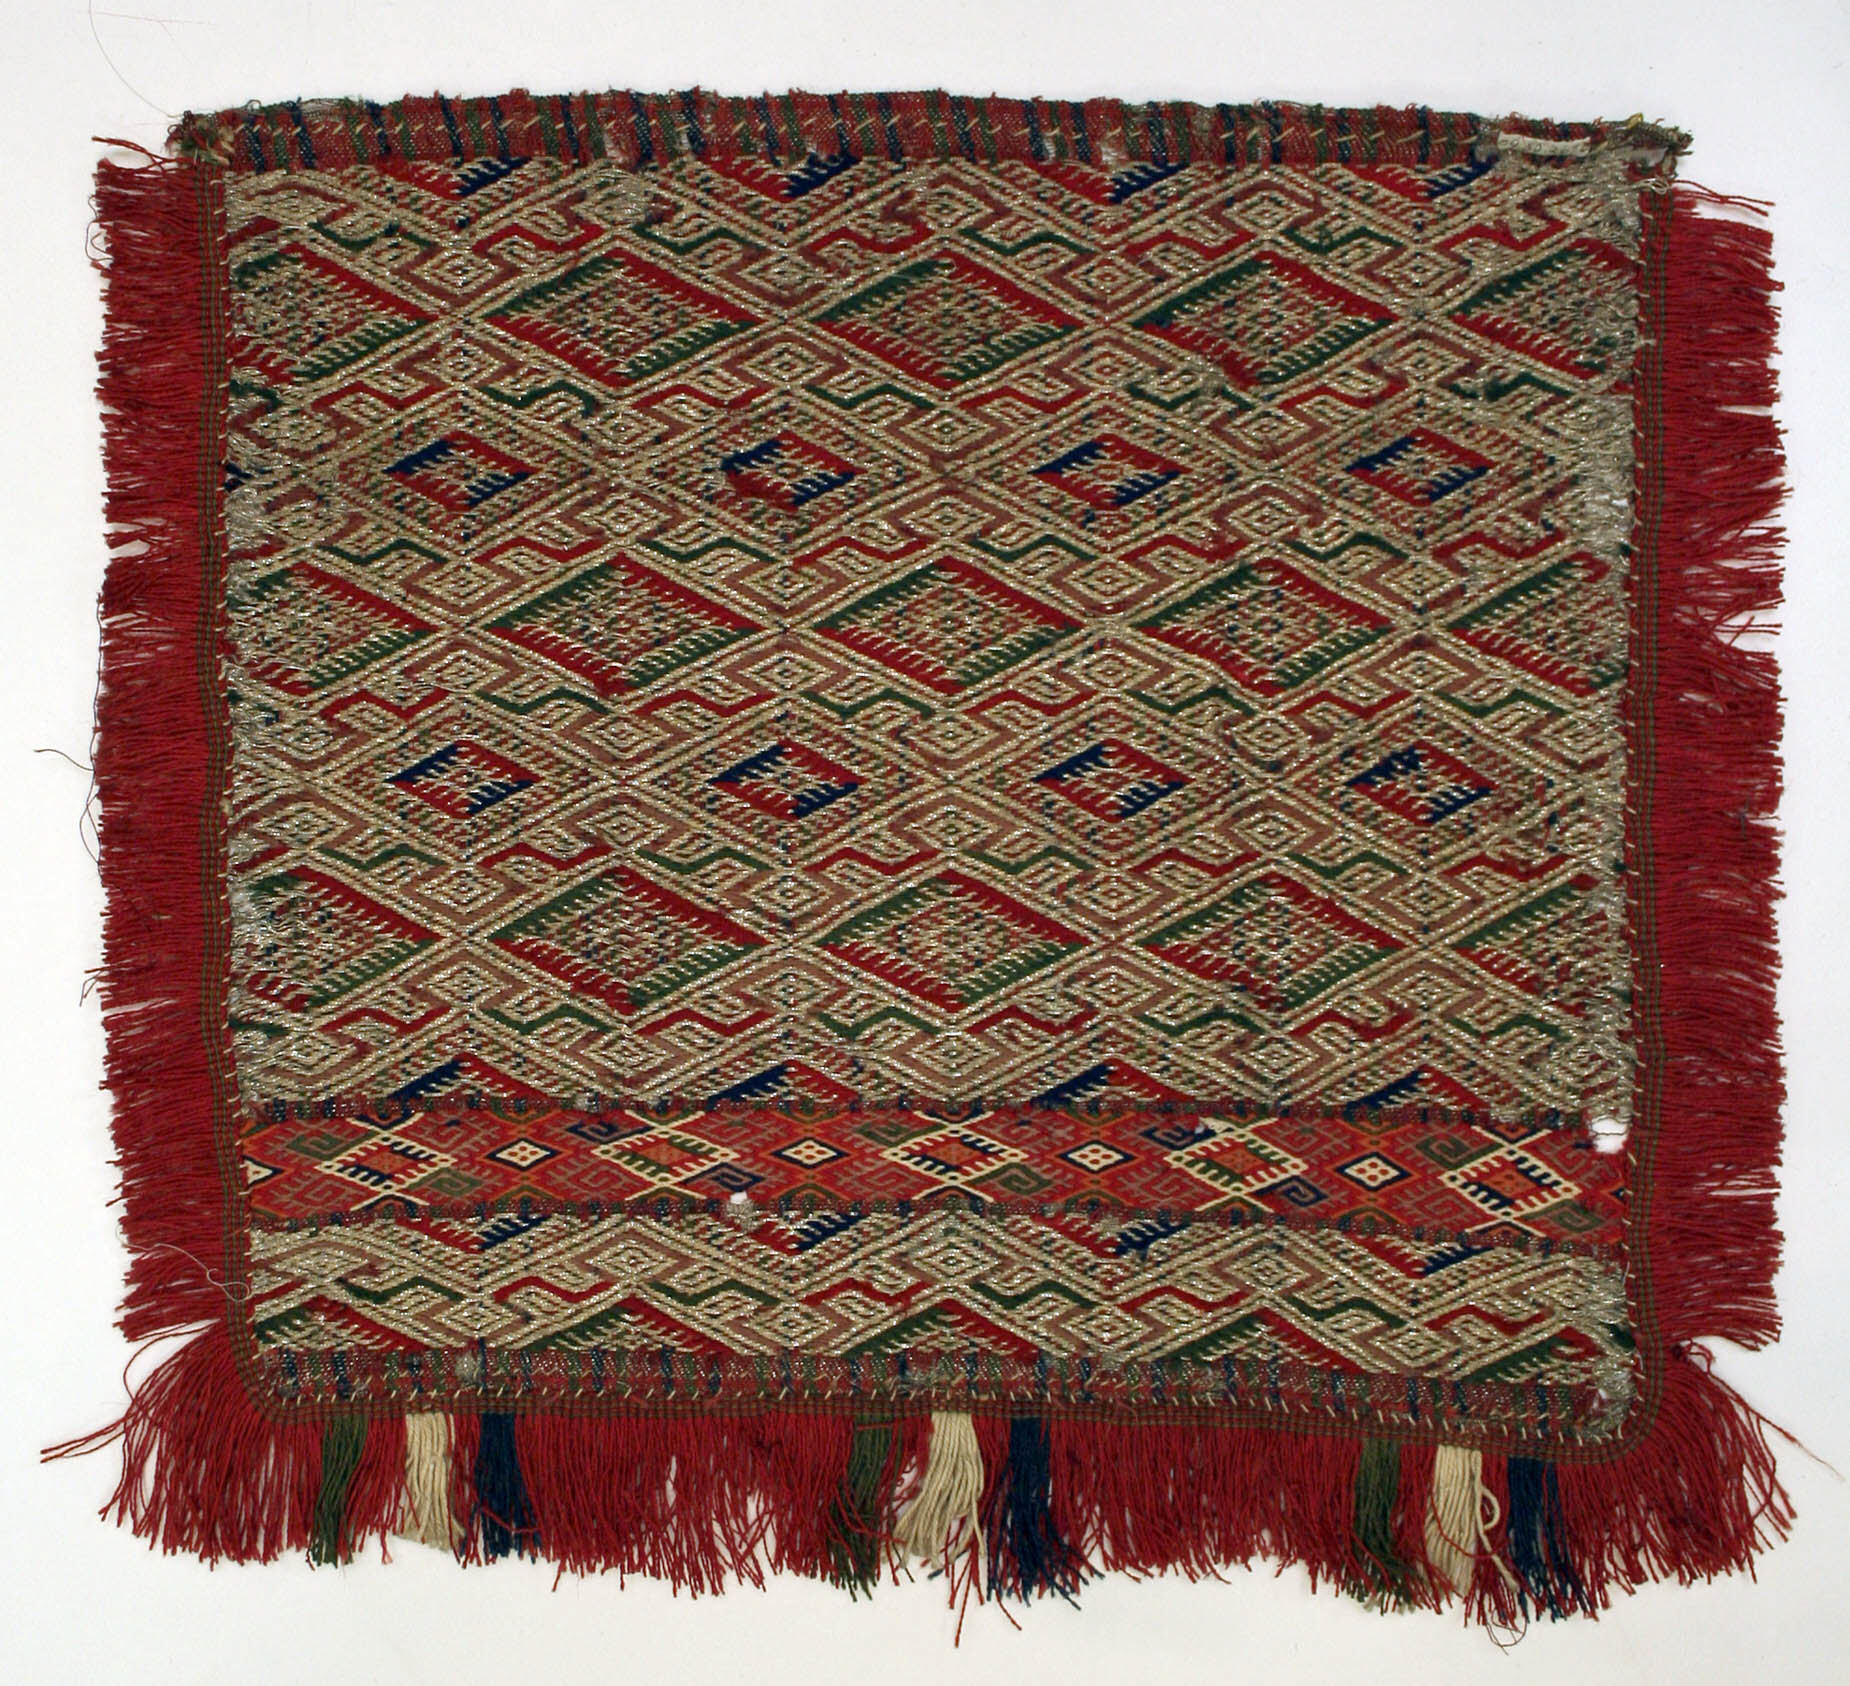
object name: apron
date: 1801-1900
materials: wool